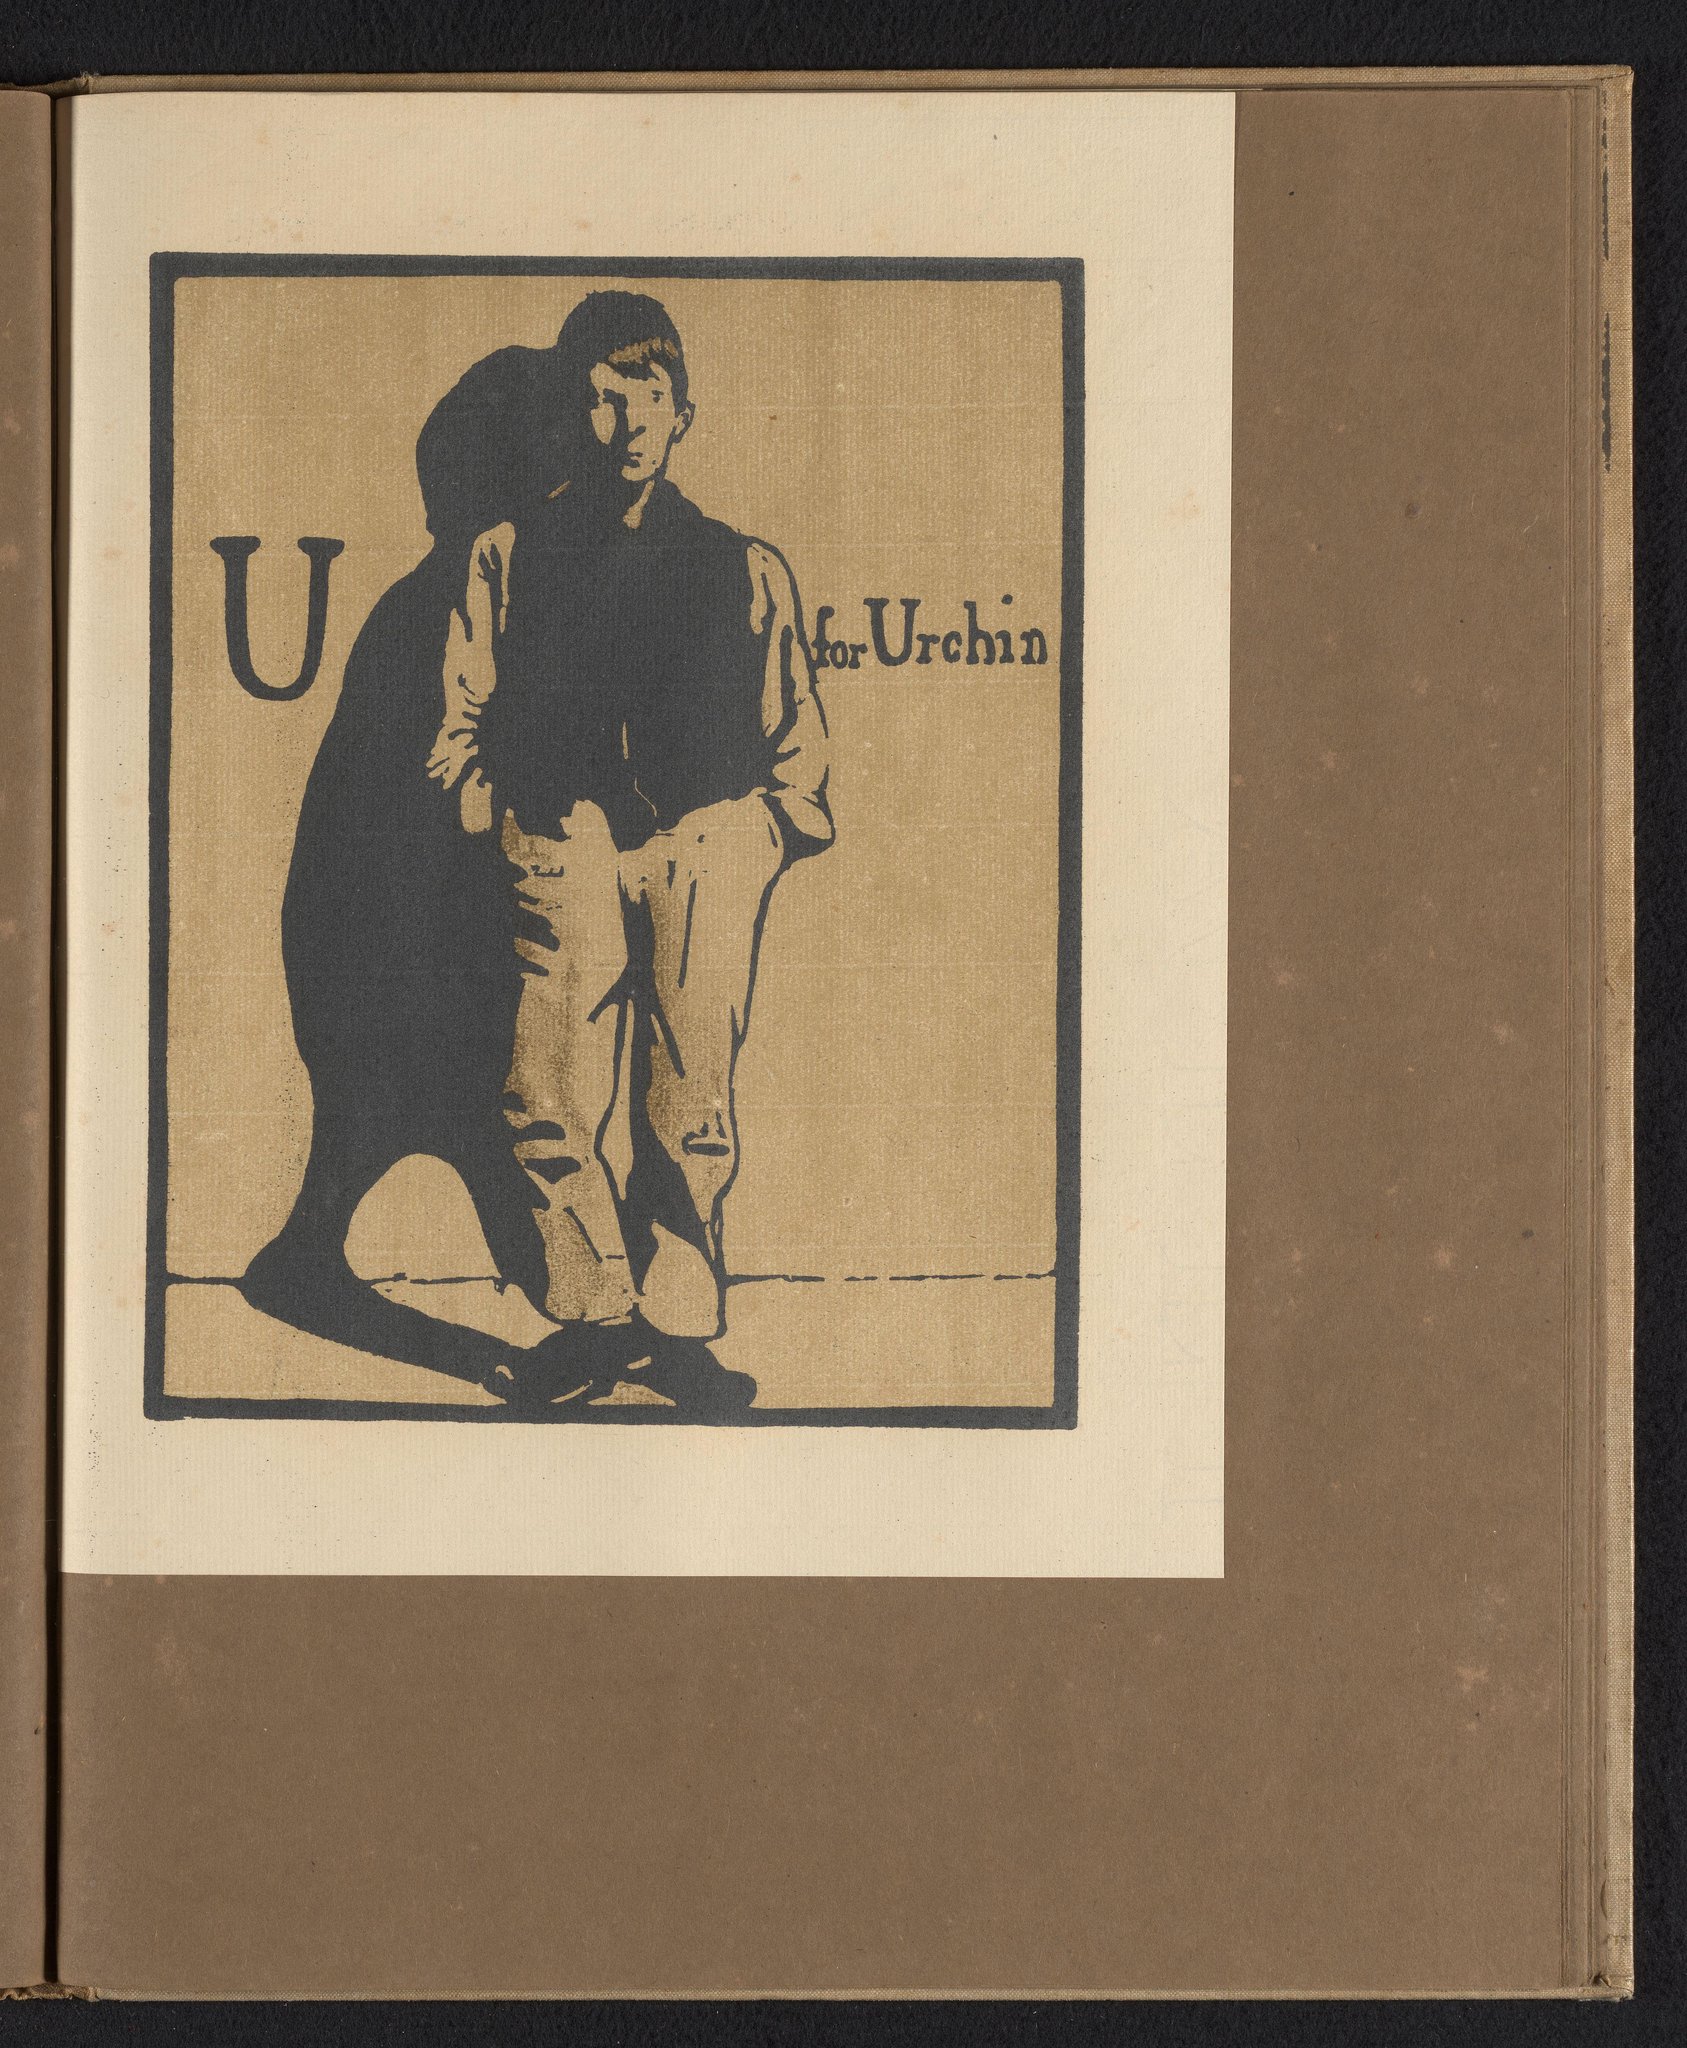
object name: print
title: U for Urchin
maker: william heinemann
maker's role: publisher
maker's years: 1863-1920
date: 1898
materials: paper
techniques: lithograph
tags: boy (child between toddler and youth), bad habits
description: De serie met lithografieën is gemaakt naar ontwerpen van houtsneden door William Nicholson.